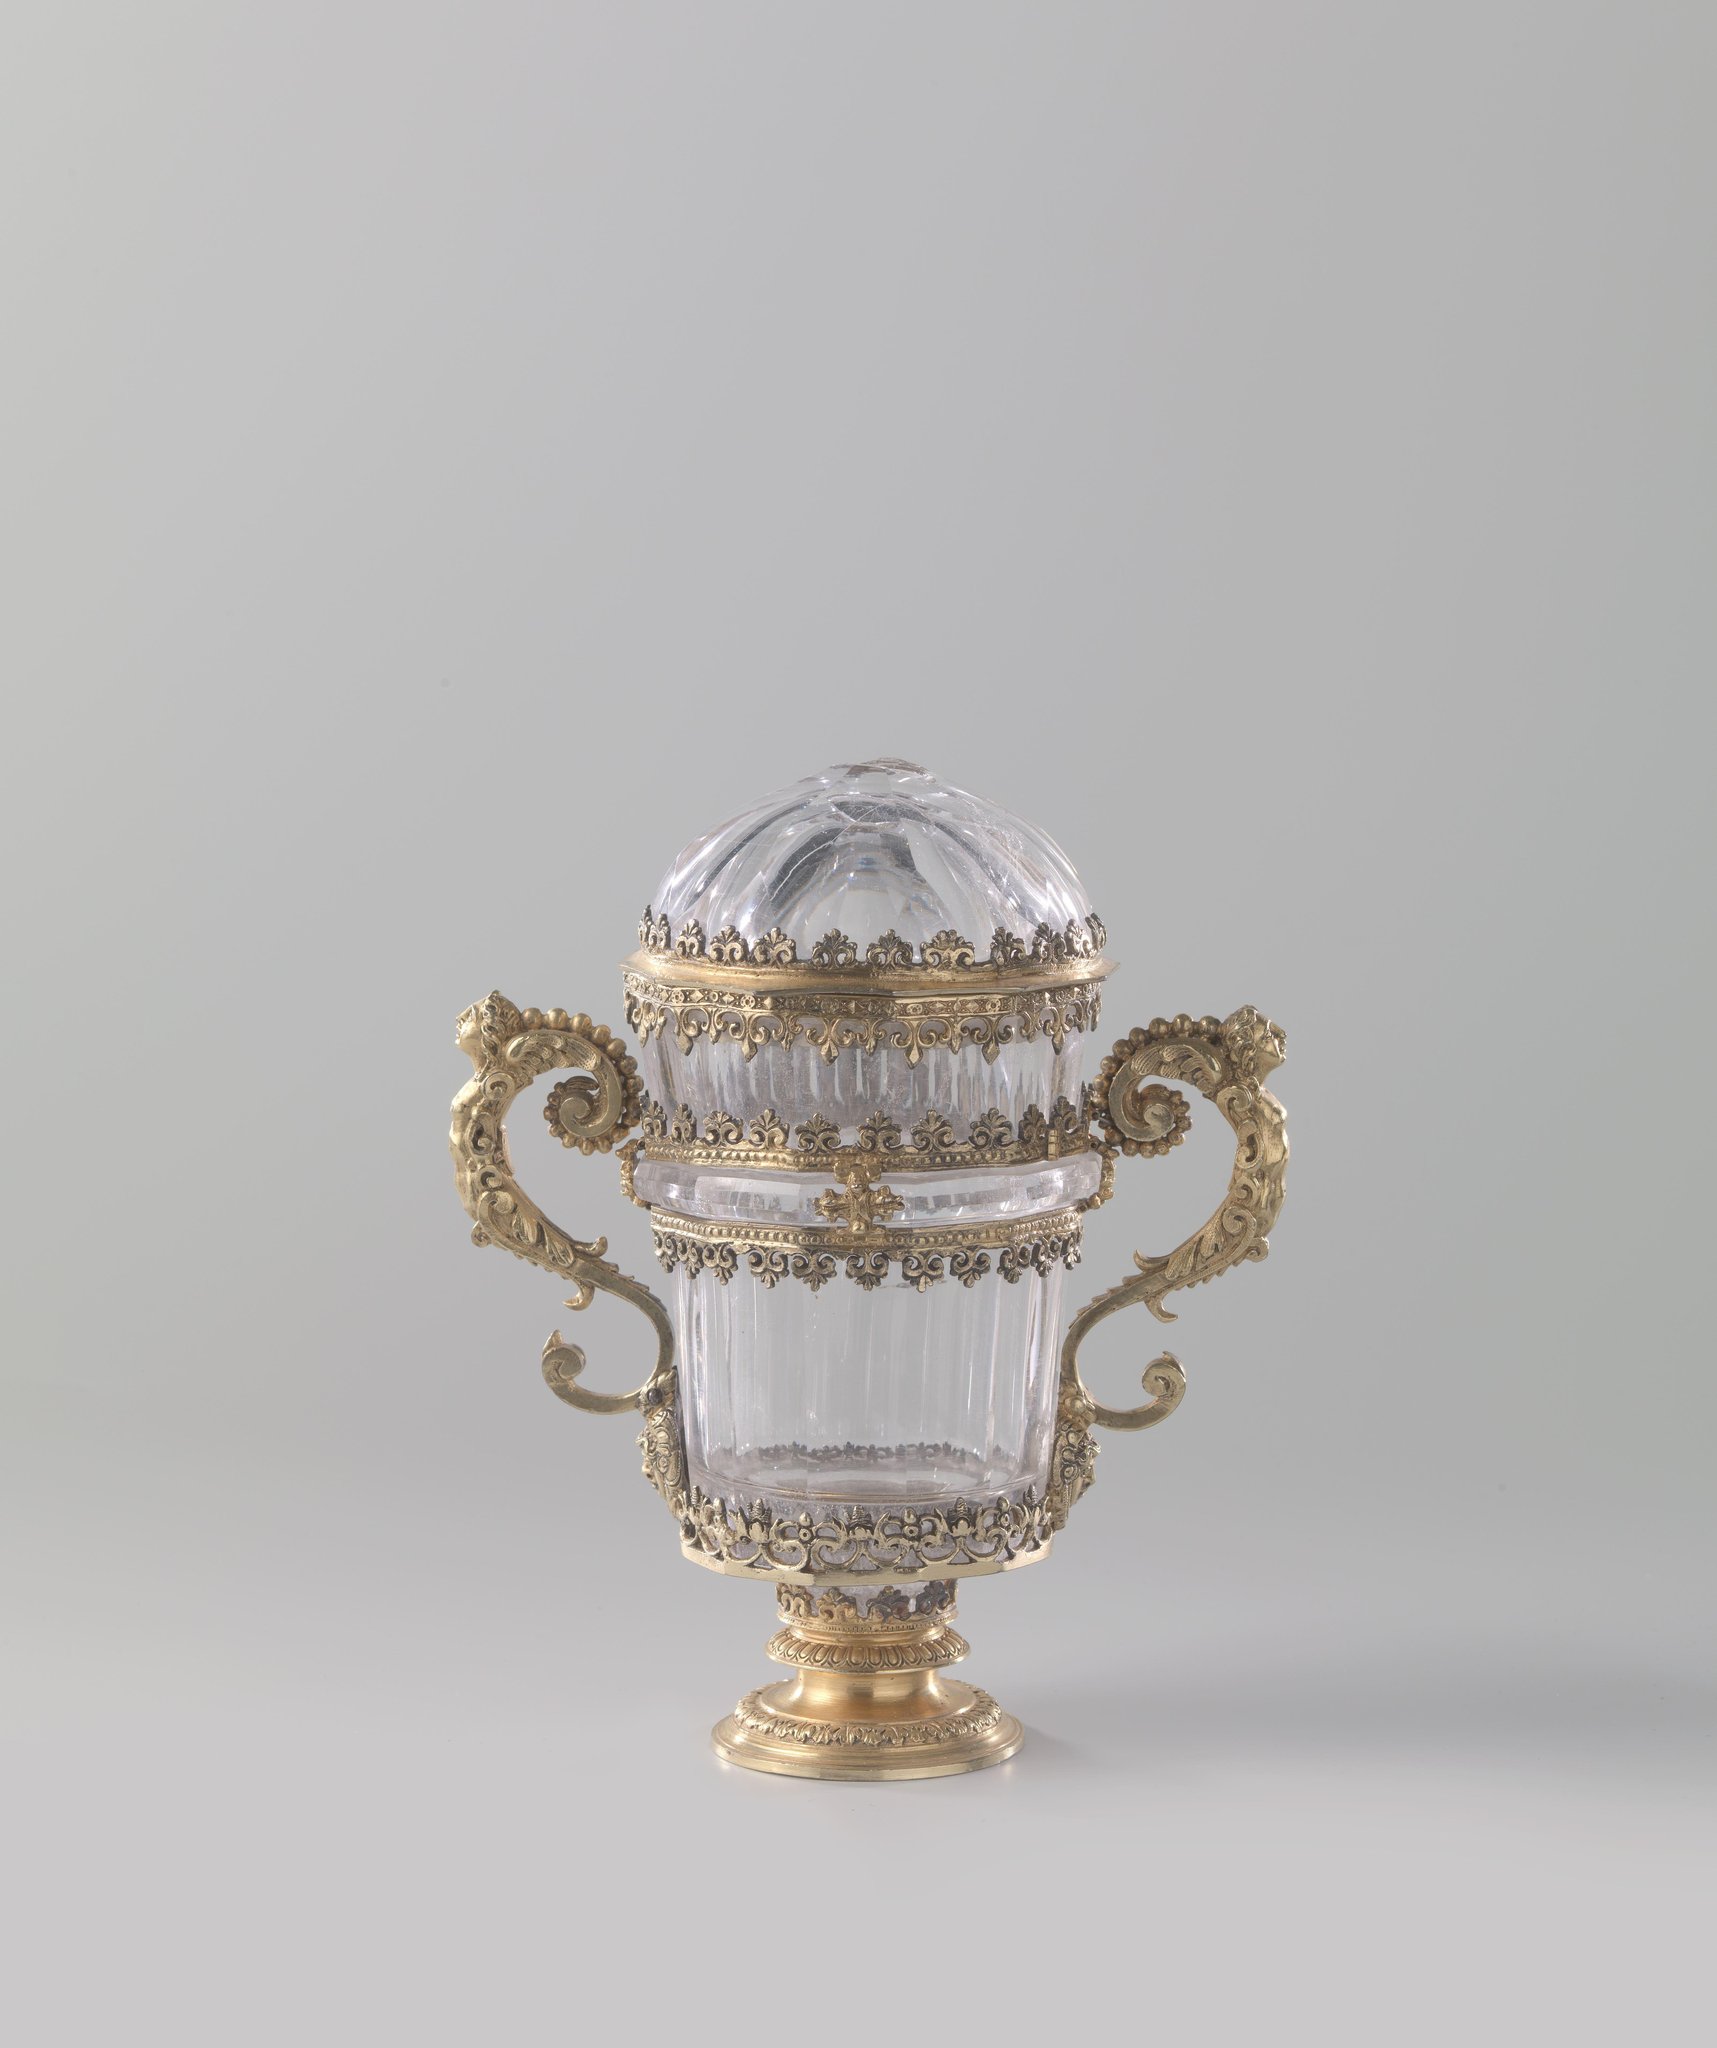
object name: coupe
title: Lidded coupe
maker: Anonymous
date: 1400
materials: silver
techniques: gilding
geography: france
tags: ornament ~ hybrid beings; human and animal forms mixed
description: Deksel van bergkristal met verguld zilveren voet, oren en montuur. Het koepelvormige deksel is geslepen in twaalf verticale facetten.